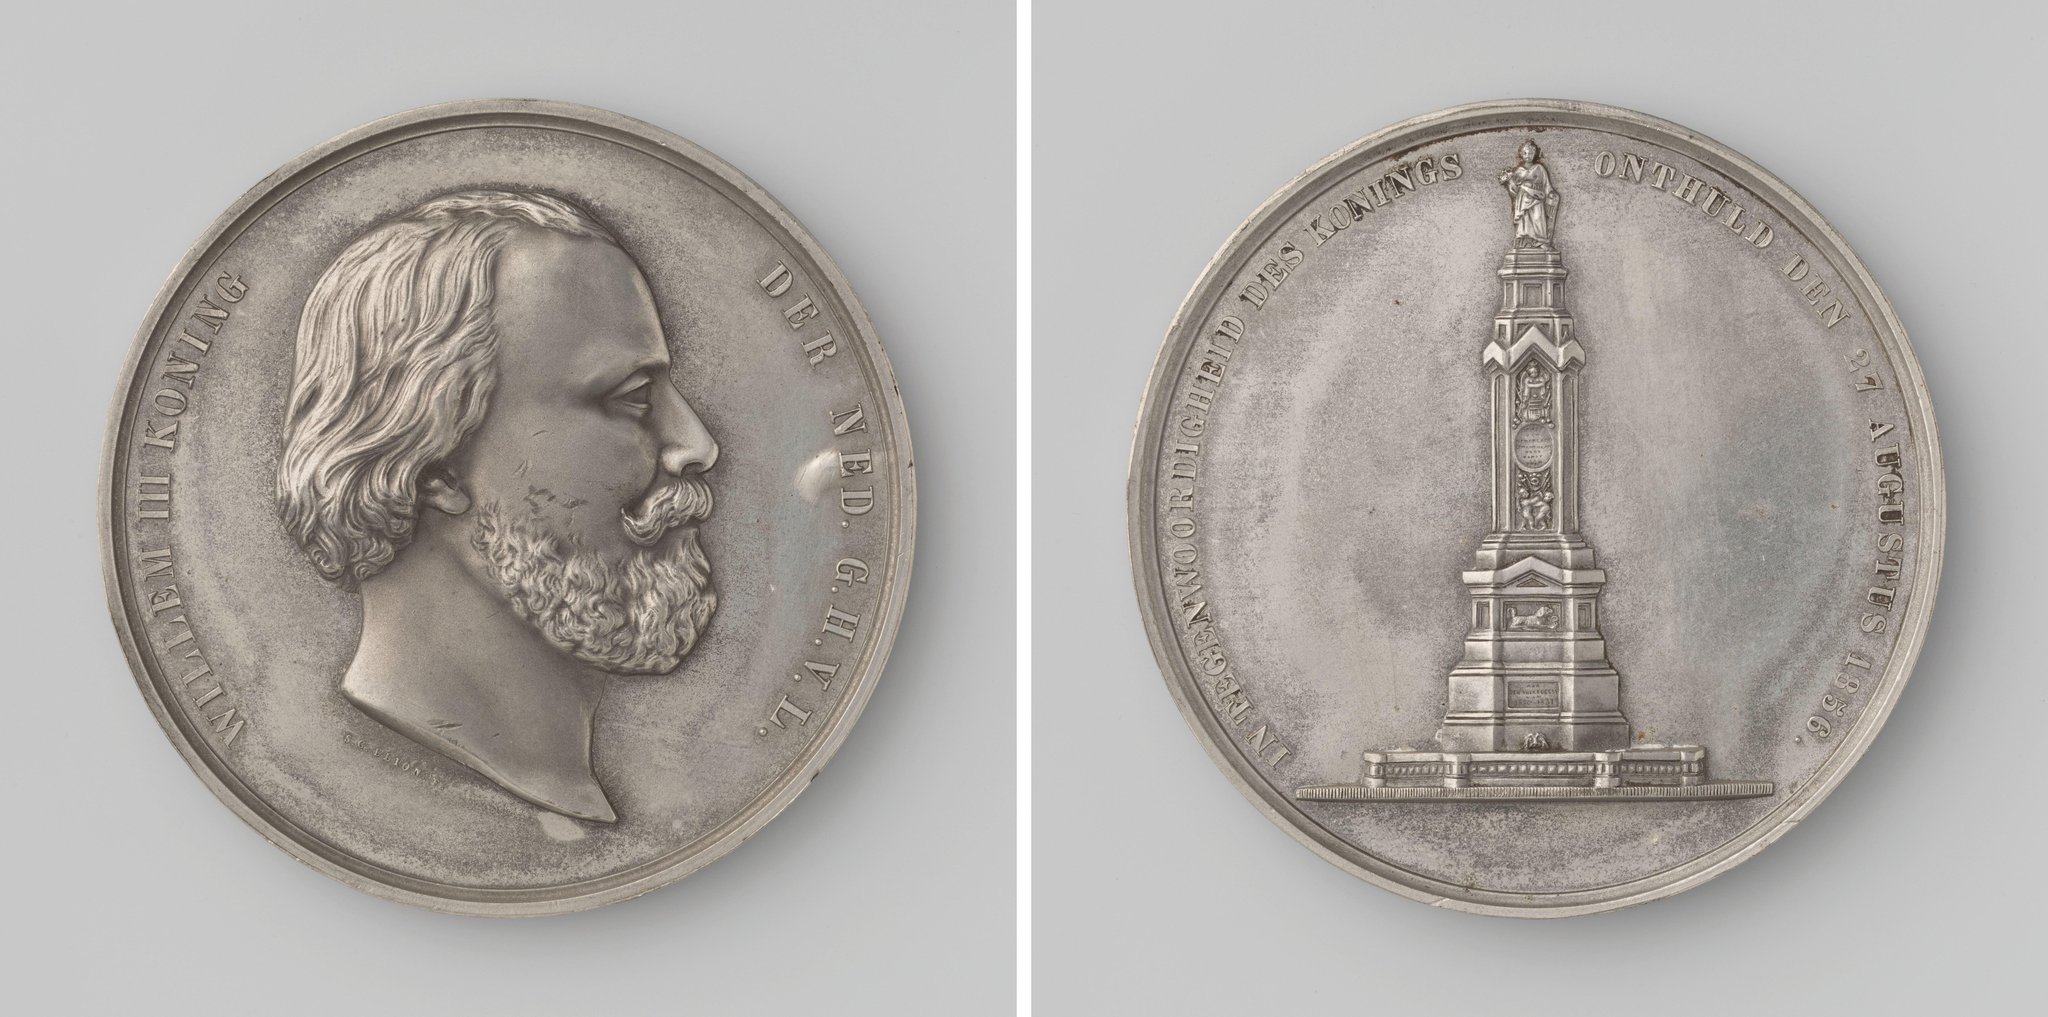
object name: history medal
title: Onthulling van het Monument op de Dam te Amsterdam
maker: samuel cohen elion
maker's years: 1815-1880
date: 1856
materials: tin